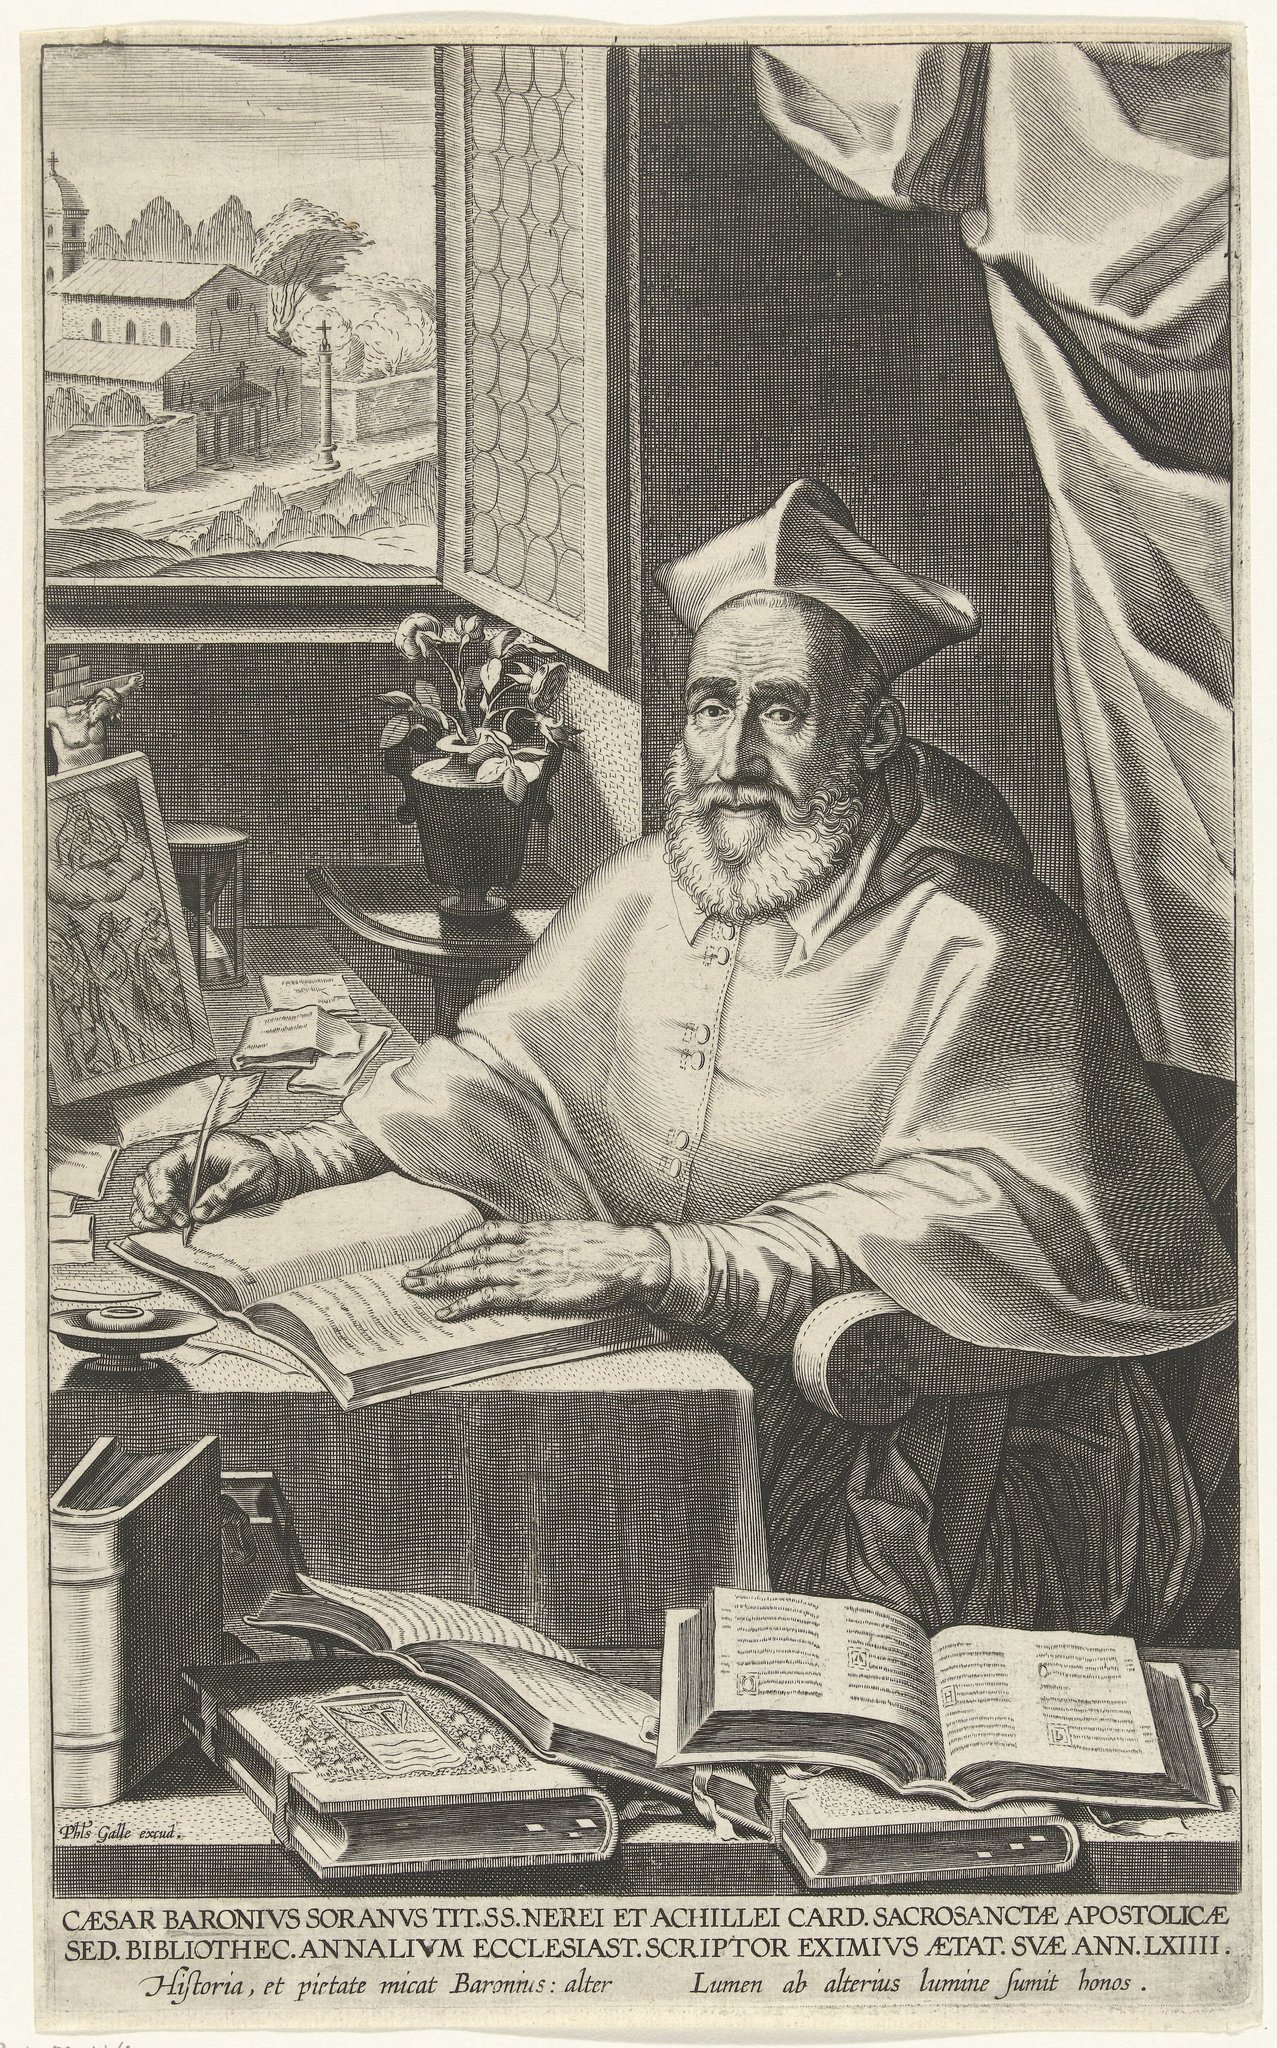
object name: book illustration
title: Portret van Cesare Baronio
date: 1610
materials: paper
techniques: engraving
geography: antwerp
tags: rome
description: Kardinaal Baronius zit aan een tafel en schrijft met zijn rechterhand in een openliggend boek. Op zijn schrijftafel verscheidene religieuze voorwerpen. Een open raam geeft uitzicht op de SS Nereo ed Achillio te Rome